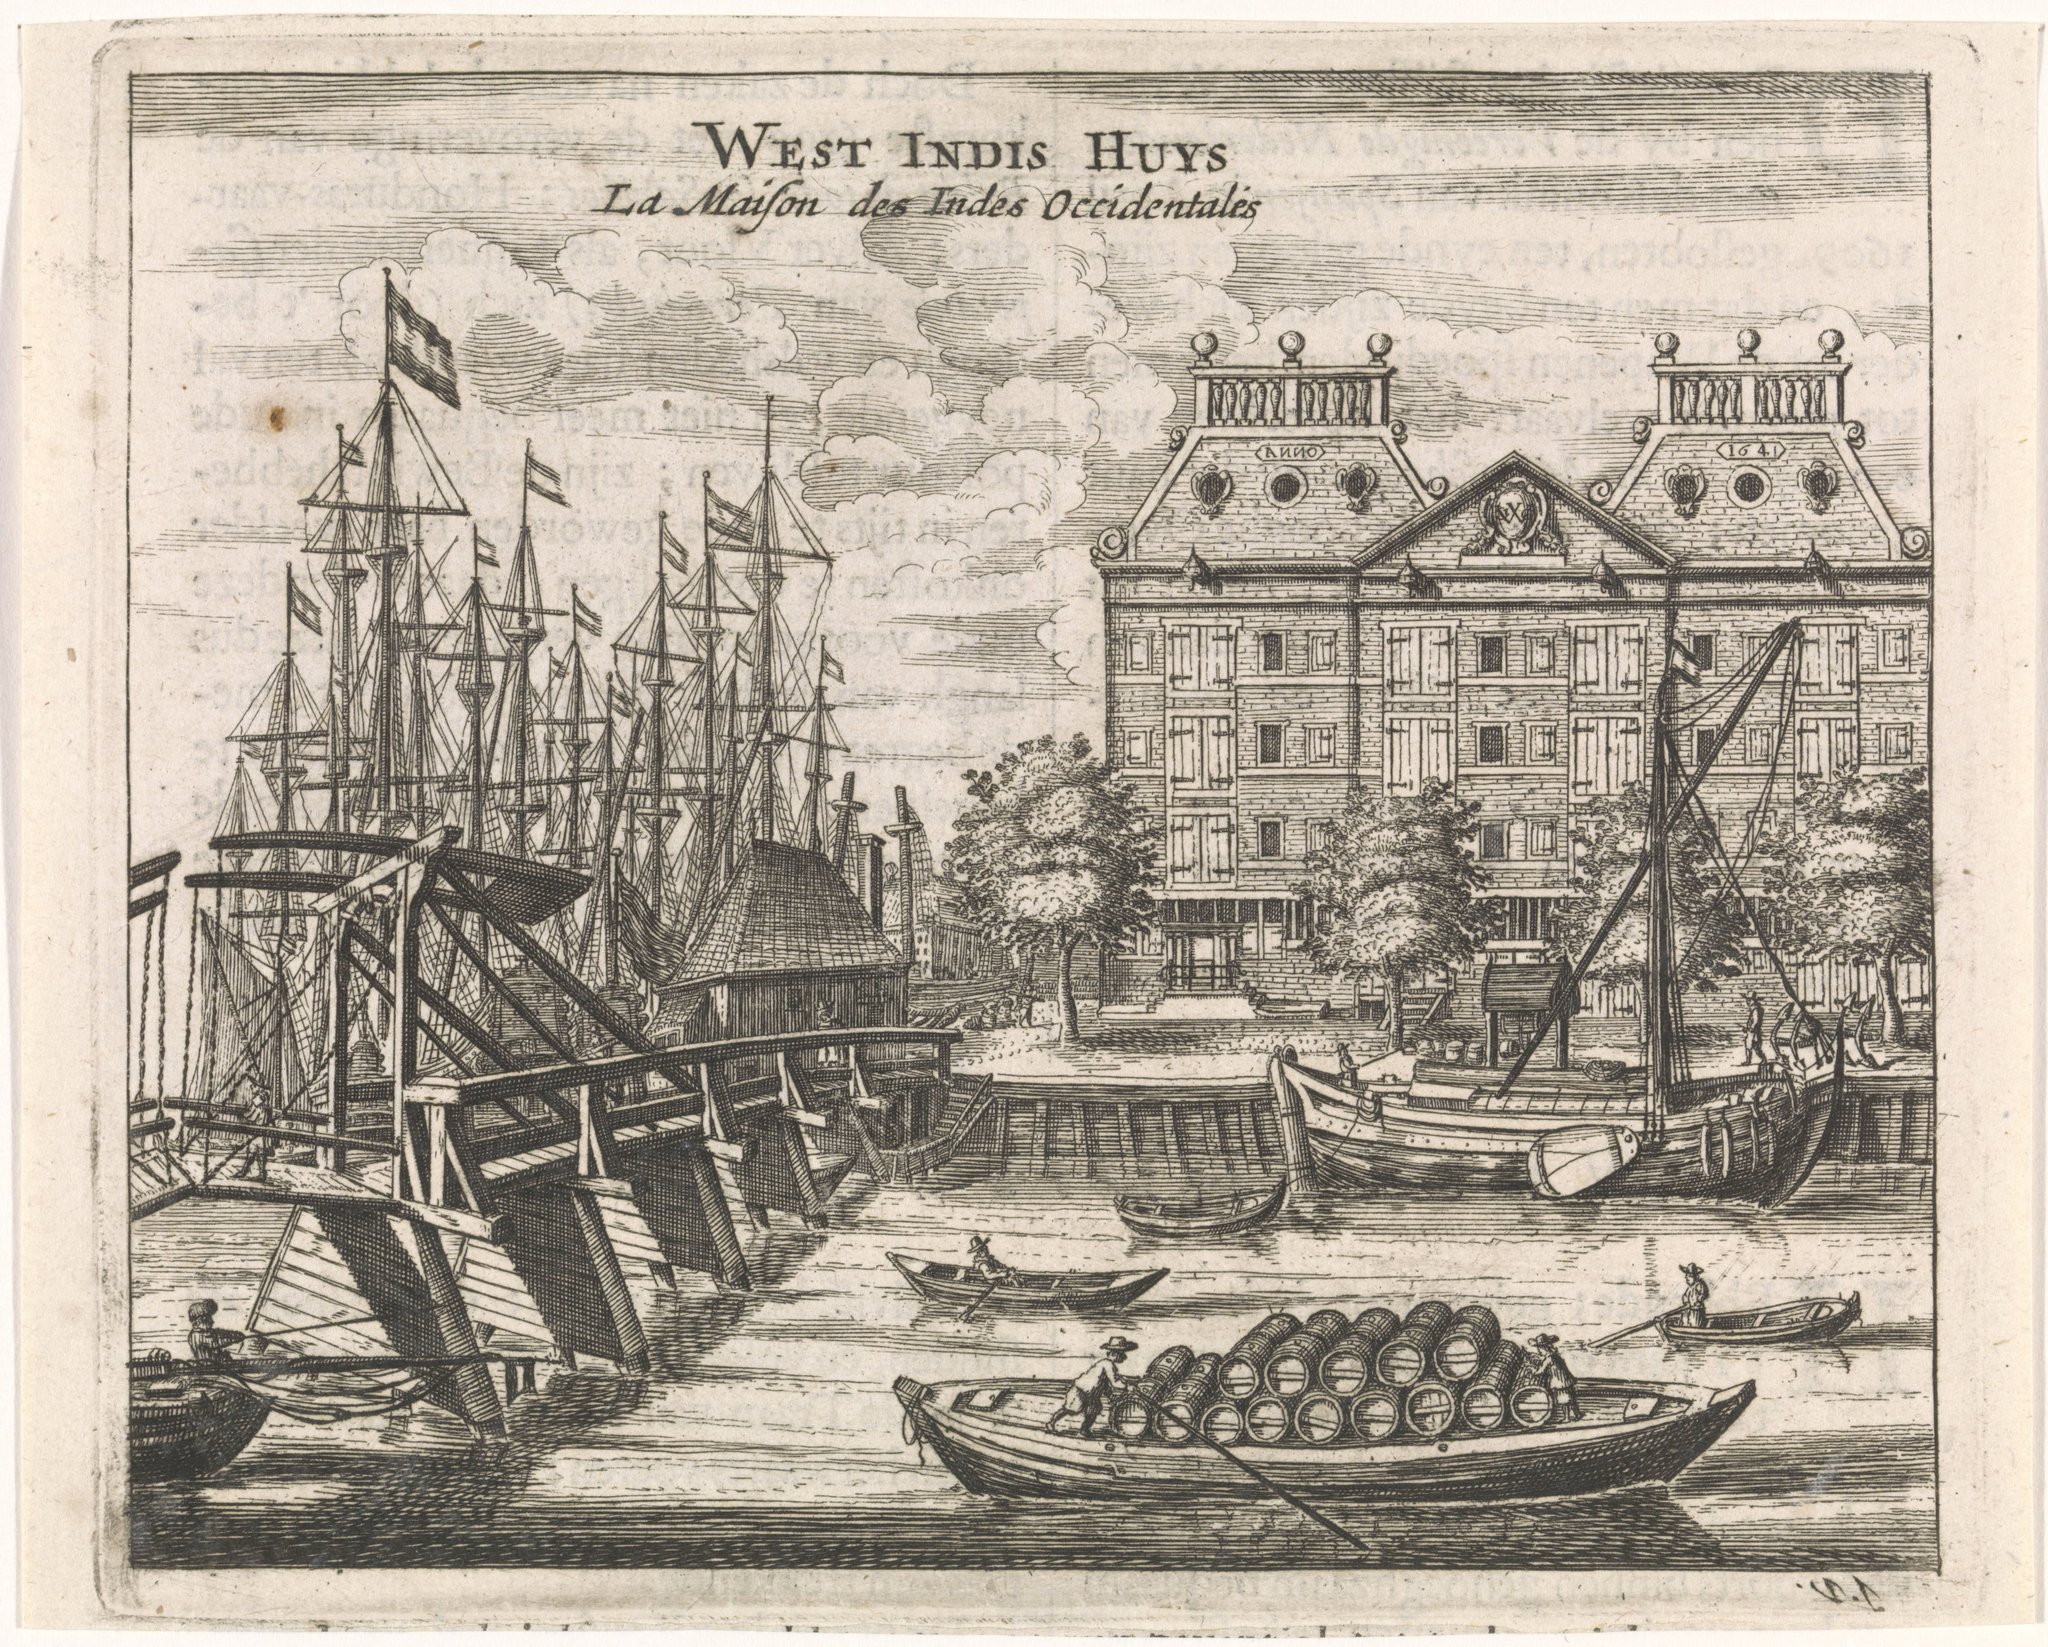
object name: book illustration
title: West Indis Huys / La Maison des Indes Occidentales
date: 1665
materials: paper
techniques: engraving, etching, letterpress printing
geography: amsterdam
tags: warehouse (~ harbour), trade-company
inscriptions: collector's mark: Lugt 2228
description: Prent gebruikt in: Domselaer, Tobias en Isaac Commelin. Beschryvinge van Amsterdam : haar eerste oorspronk uyt den huyze der heeren van Aemstel en Aemstellant (…). 6 delen. Amsterdam: Marcus Willemsz van Doornick, 1665. Eerste bekende staat (zonder Franse titel, zie RP-P-AO-25-67-1) ook gebruikt in: Fockens, Melchior. Beschrijving Der wijdt-vermaarde Koop-stadt Amstelredam, Van haar eerste beginselen, zedert den Jare 1203. oude Voorrechten, verscheyde Vergrootingenoude Voor-rechten, en verscheyde Vergrootingen (…). 3e druk. Amsterdam: Marcus Willemsz. Doornick, 1664. En in: Zesen, Philipp von. Beschrybung der Weidtberuhmde Kauf-Stadt Amstelredam / Beschreibung der Stadt Amsterdam darinnen von derselben ersten ursprunge bis auf gegenwartigen zustand (…). Amsterdam: Marcus Willemsz. Doornick, 1664. Derde bekende staat (rechtsboven genummerd: 51) ook gebruikt in verschillende latere zeventiende- en achttiende-eeuwse publicaties.